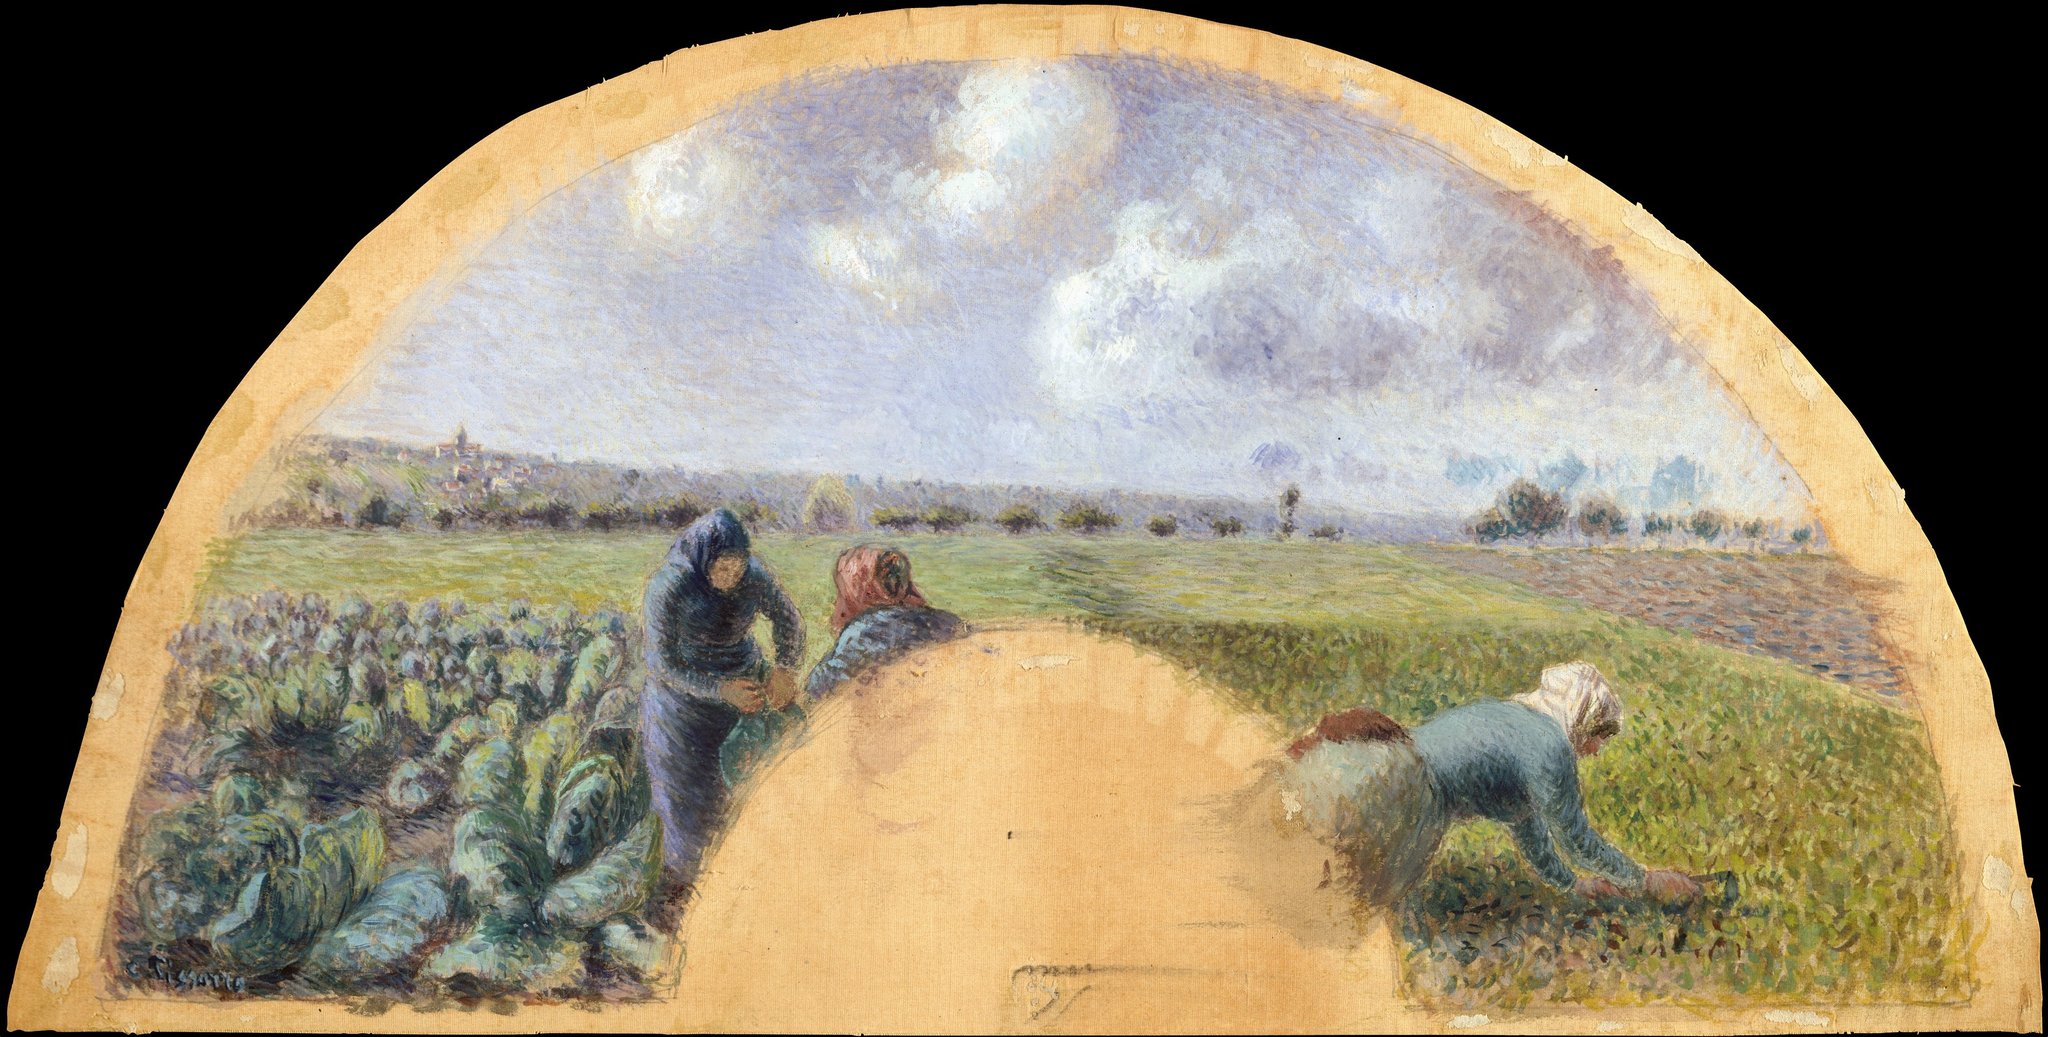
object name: drawing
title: Fan Mount: The Cabbage Gatherers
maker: camille pissarro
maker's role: artist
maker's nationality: french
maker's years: 1830-1903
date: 1878-1879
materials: gouache, silk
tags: farms,vegetables,women,agriculture,working